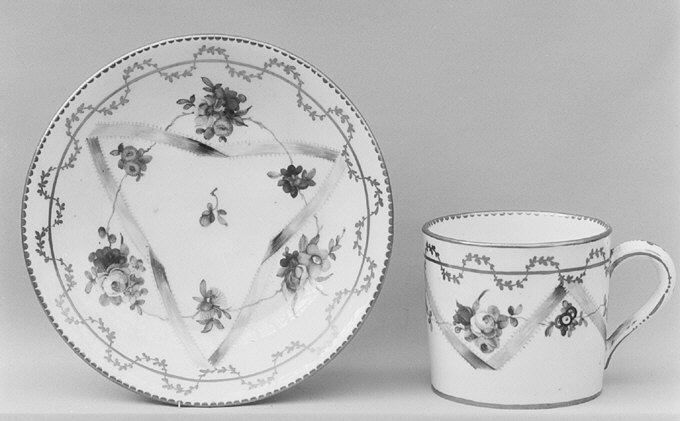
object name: cup and saucer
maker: la courtille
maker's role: factory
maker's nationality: french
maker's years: 1771-1840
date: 1775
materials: hard paste porcelain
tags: flowers